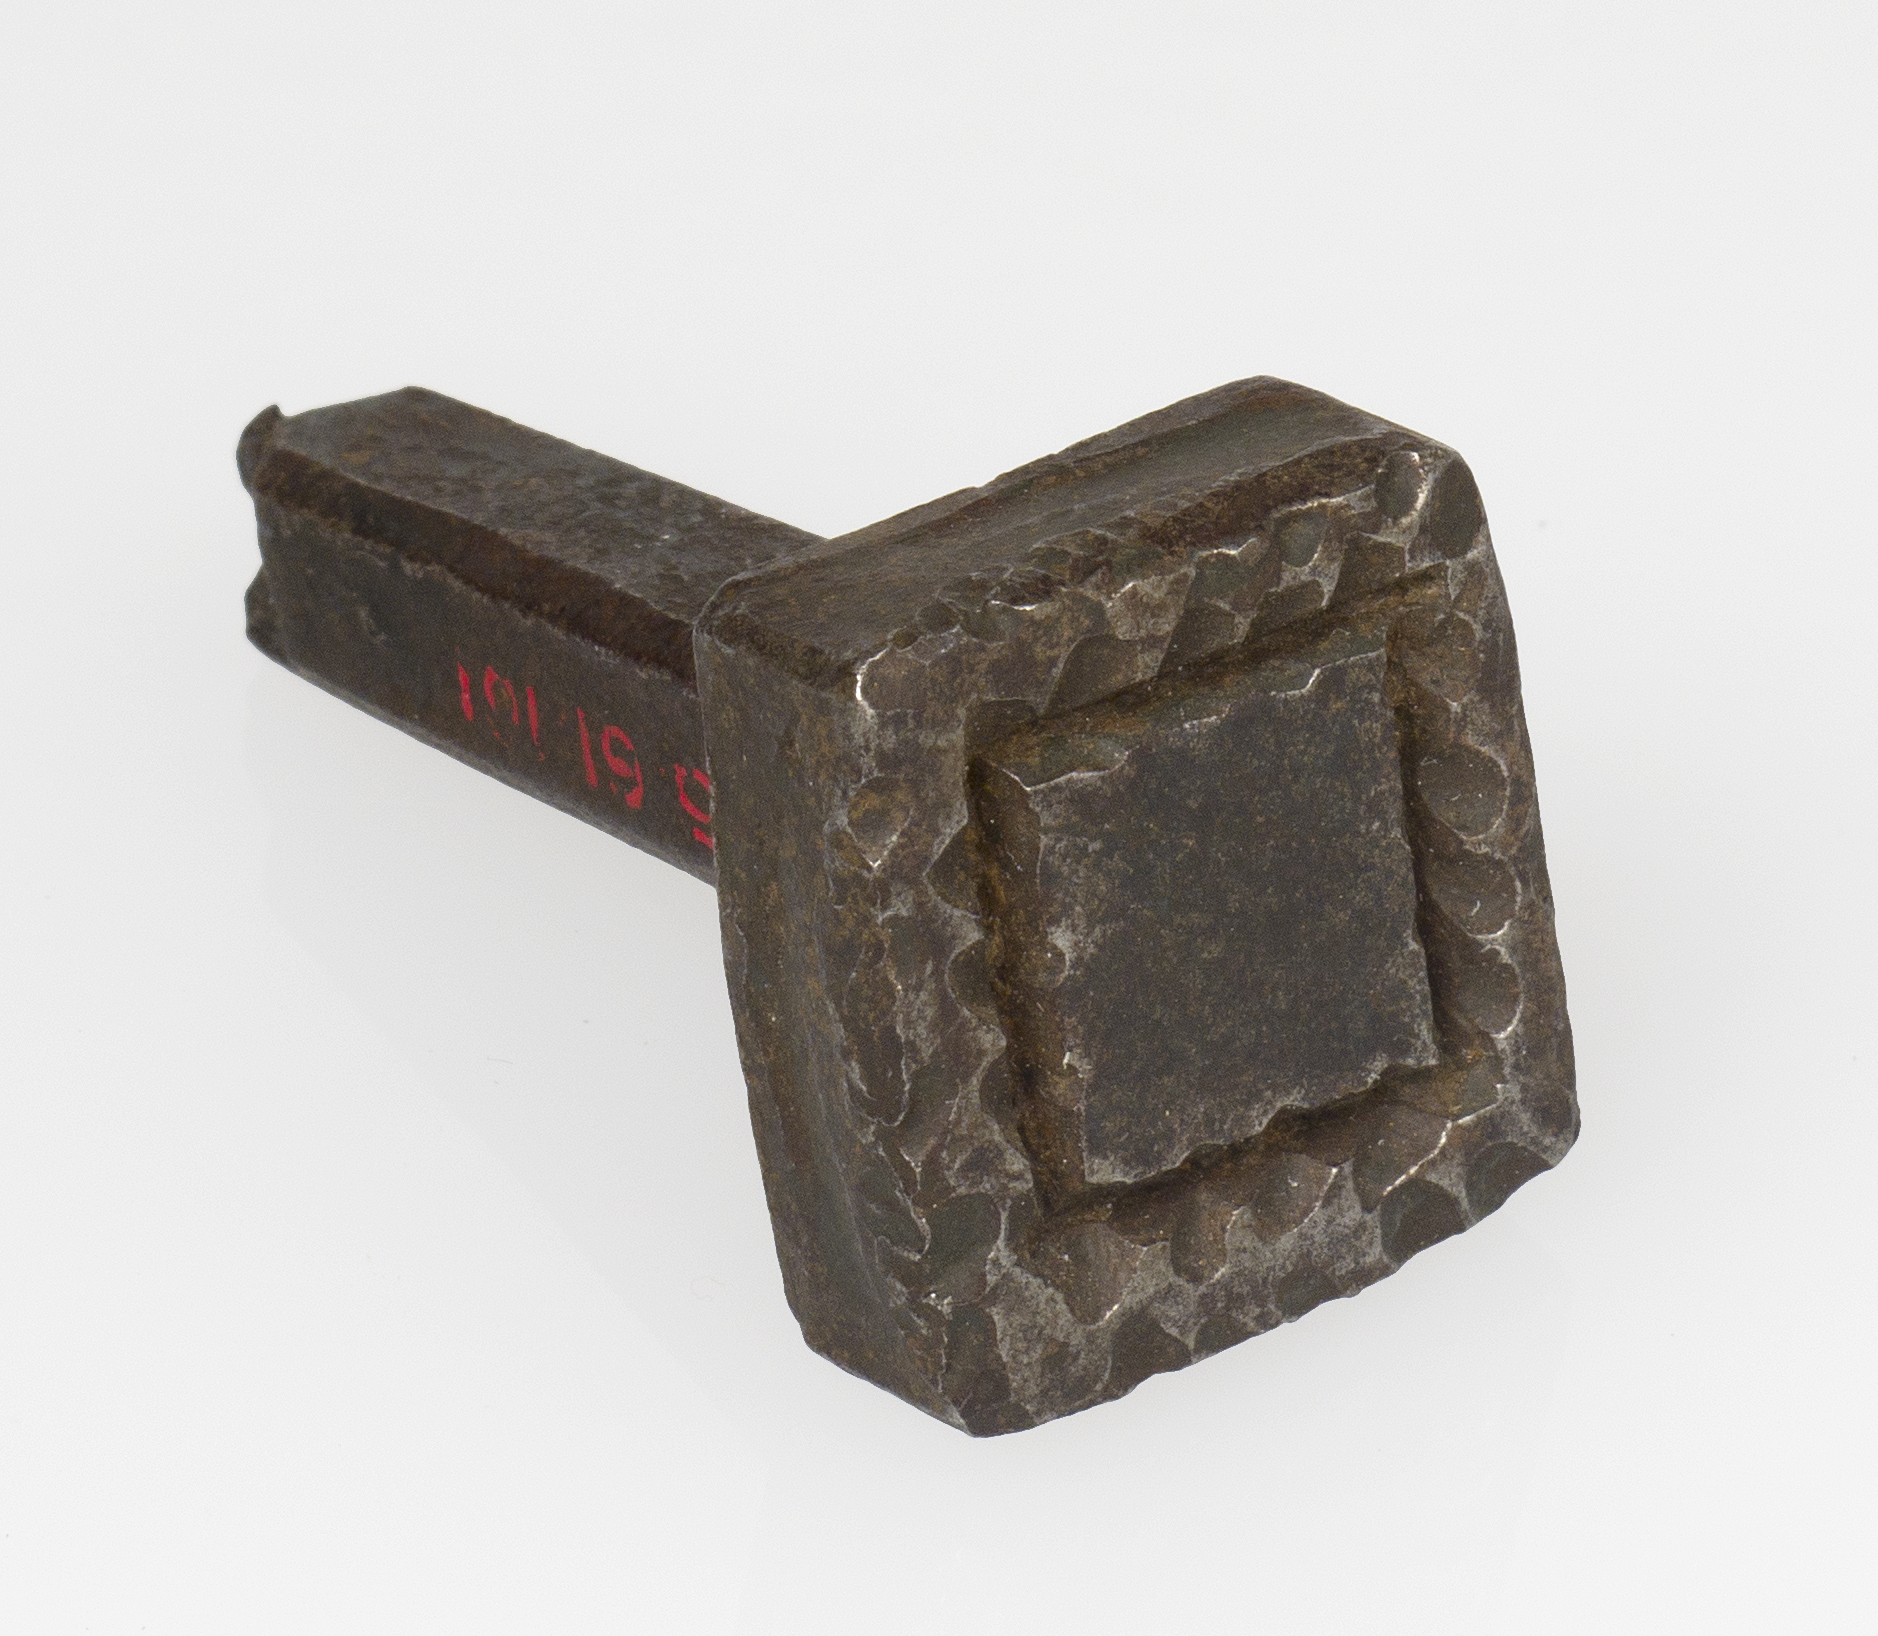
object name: nail head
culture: european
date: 1401-1600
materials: iron